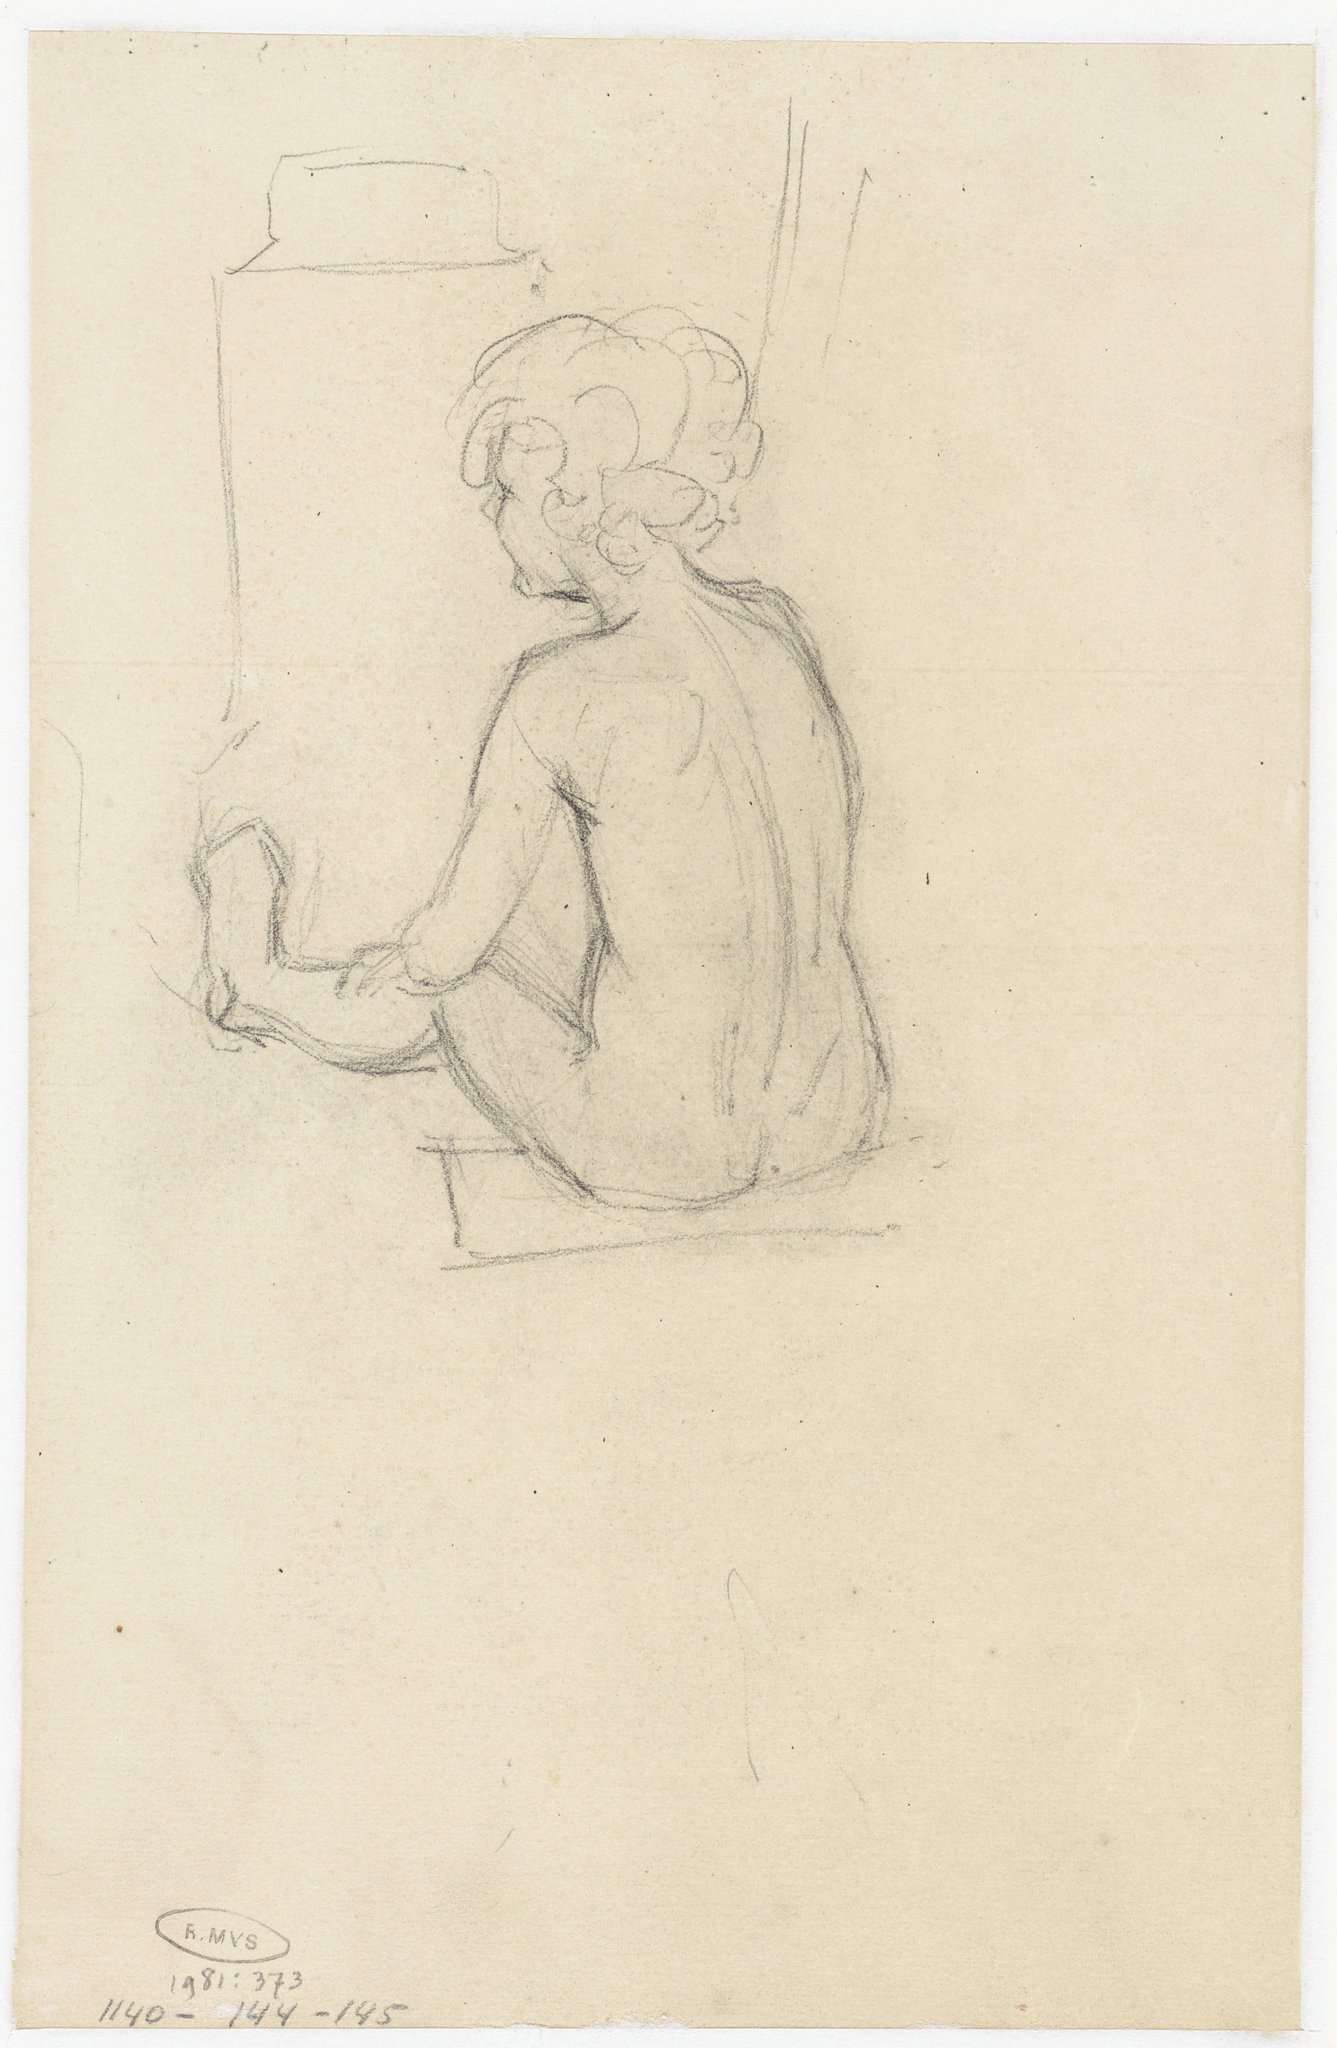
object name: drawing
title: Zittend naakt meisje, op de rug gezien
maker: jozef israëls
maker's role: draughtsman, painter, print maker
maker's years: 1824-1911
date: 1834-1911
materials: chalk, paper